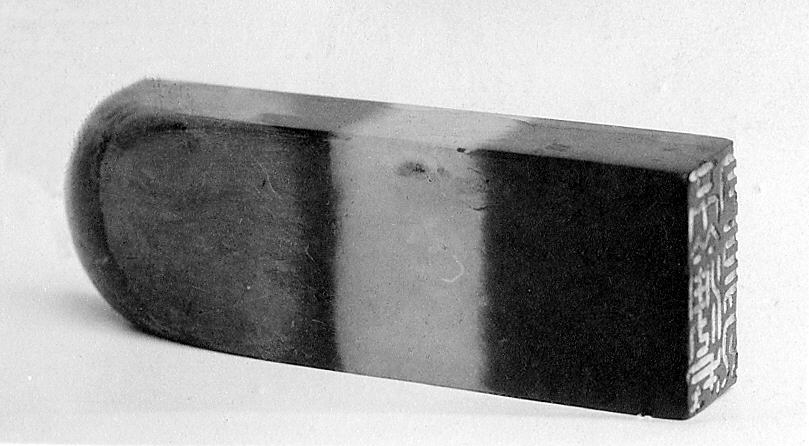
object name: seal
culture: chinese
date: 1900-1927